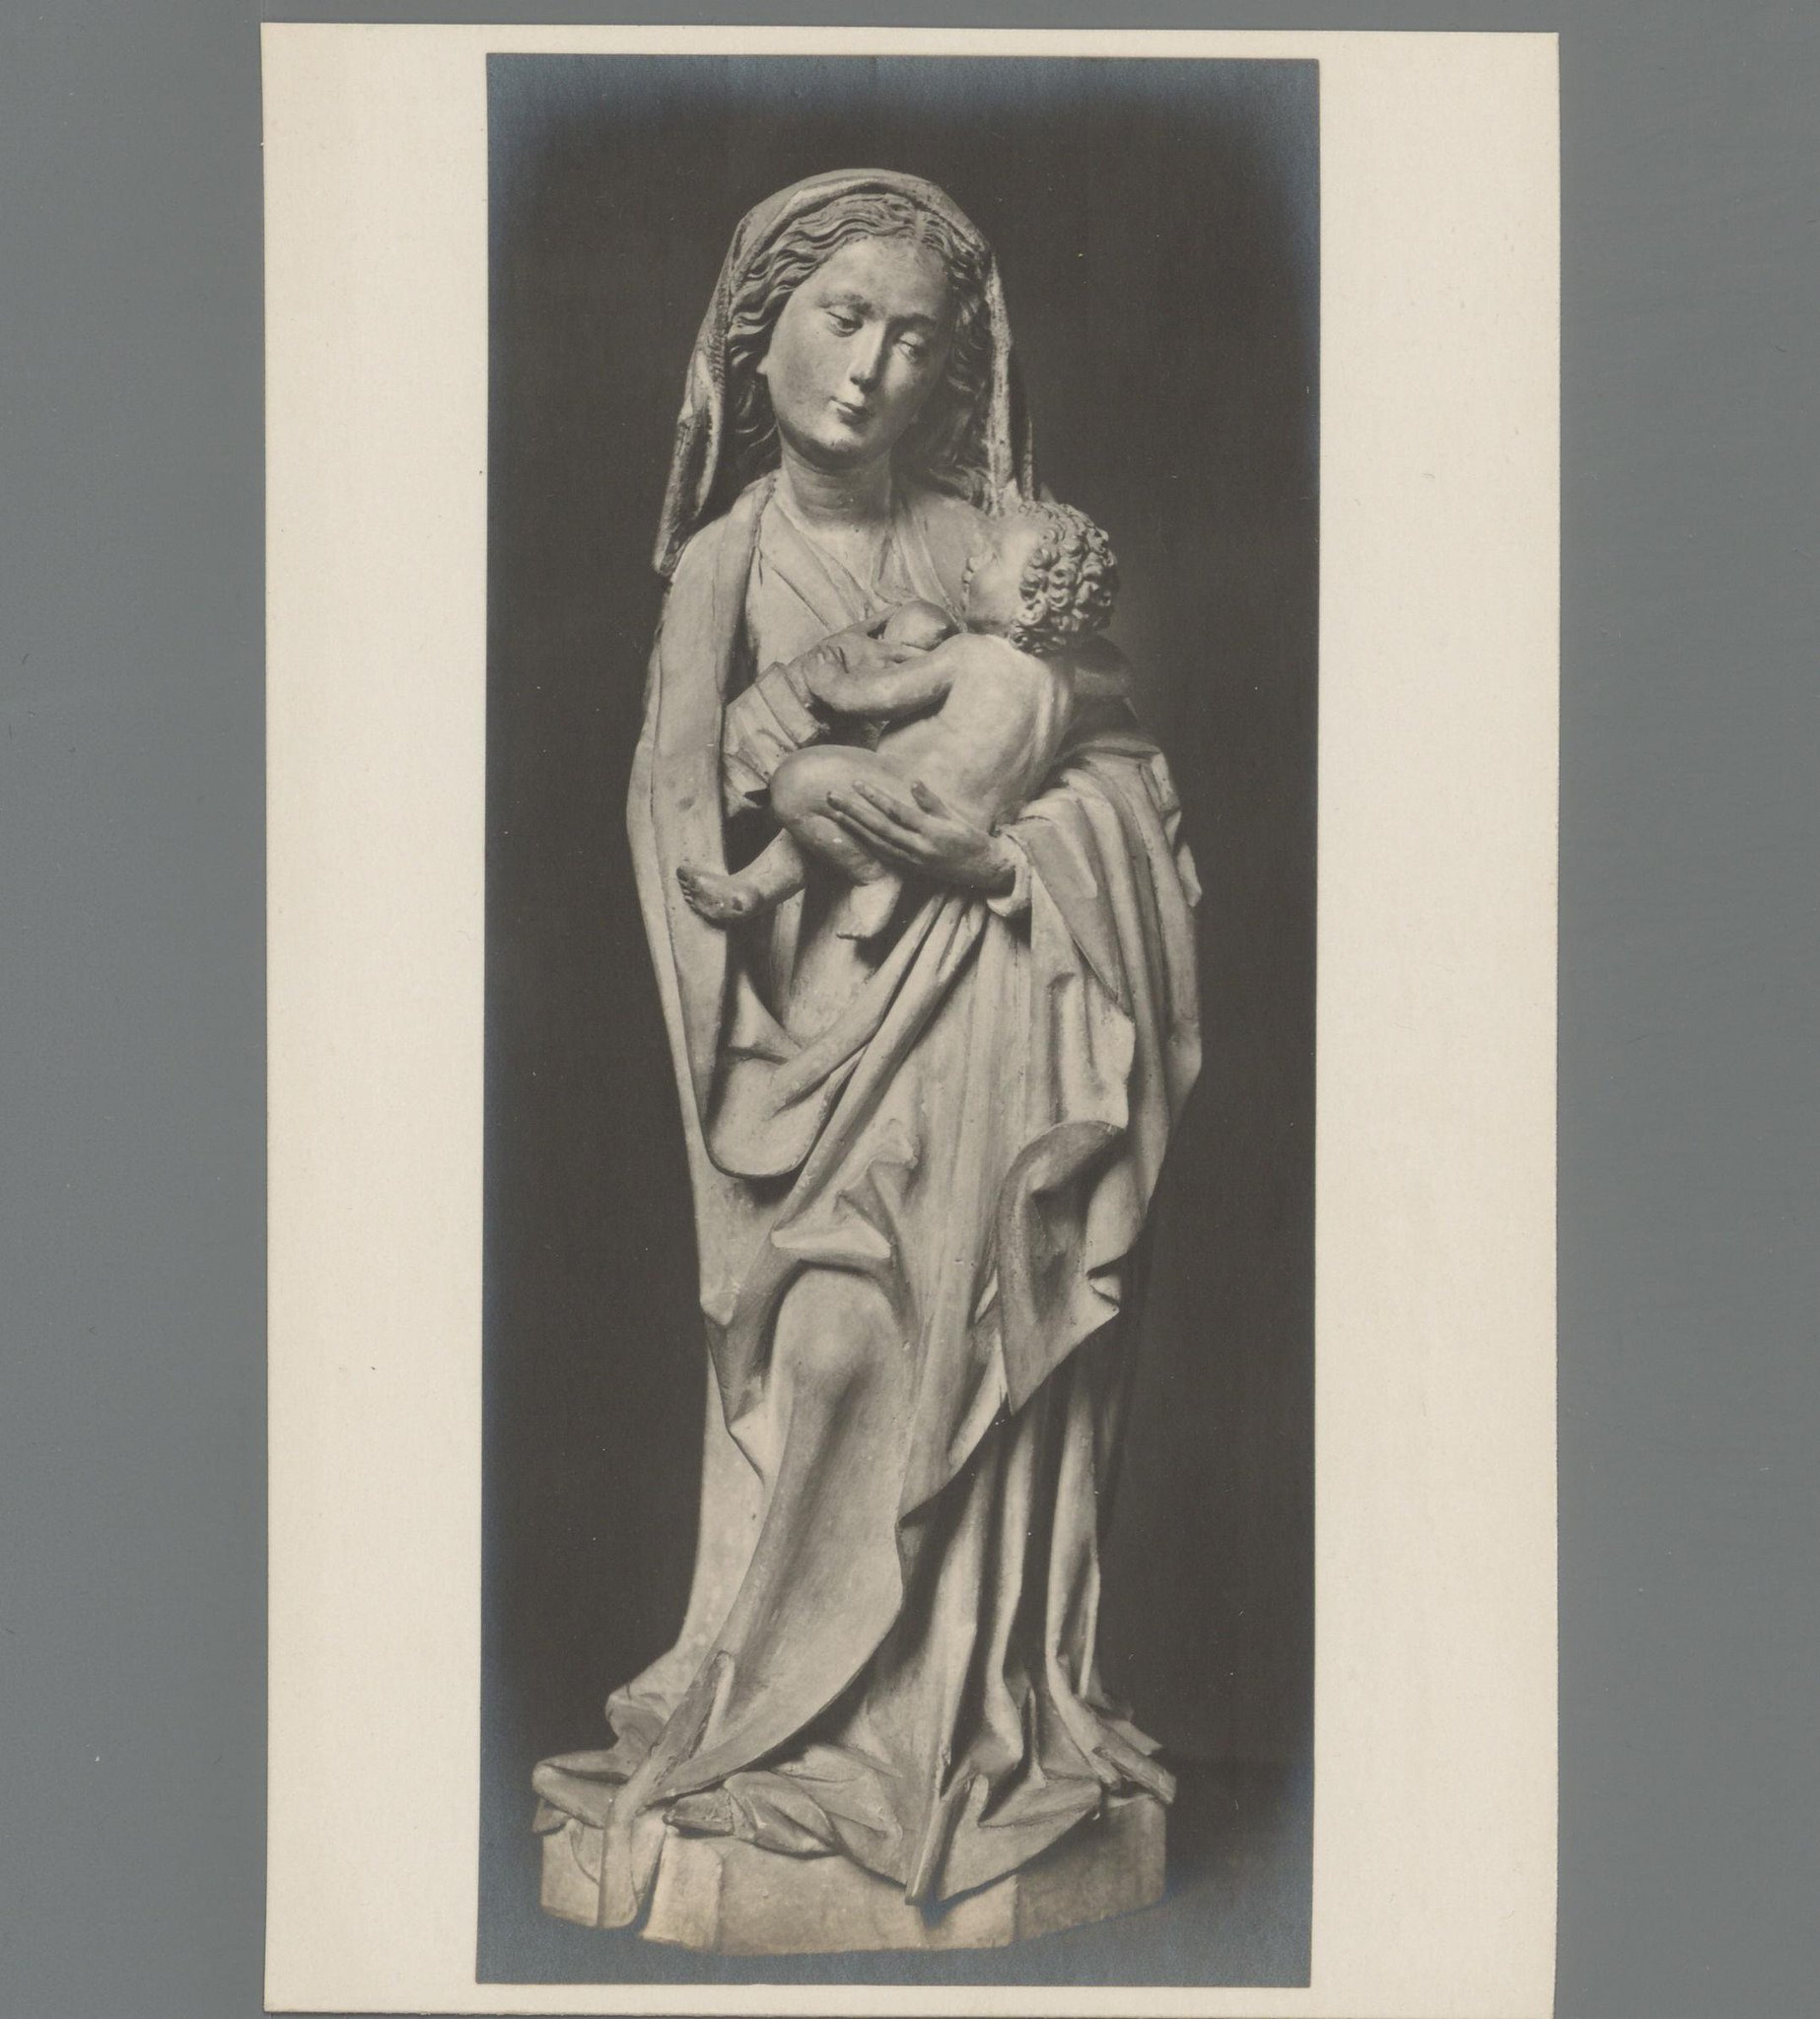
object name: photograph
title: Kaiser-Friedrich-Museum Berlin. Maria mit Kind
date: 1904-1930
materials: photographic support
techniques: photography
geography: berlin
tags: madonna: i.e. mary with the christ-child, statues, paintings, etc. ~ objects of worship in roman religion, permanent exhibition, museum